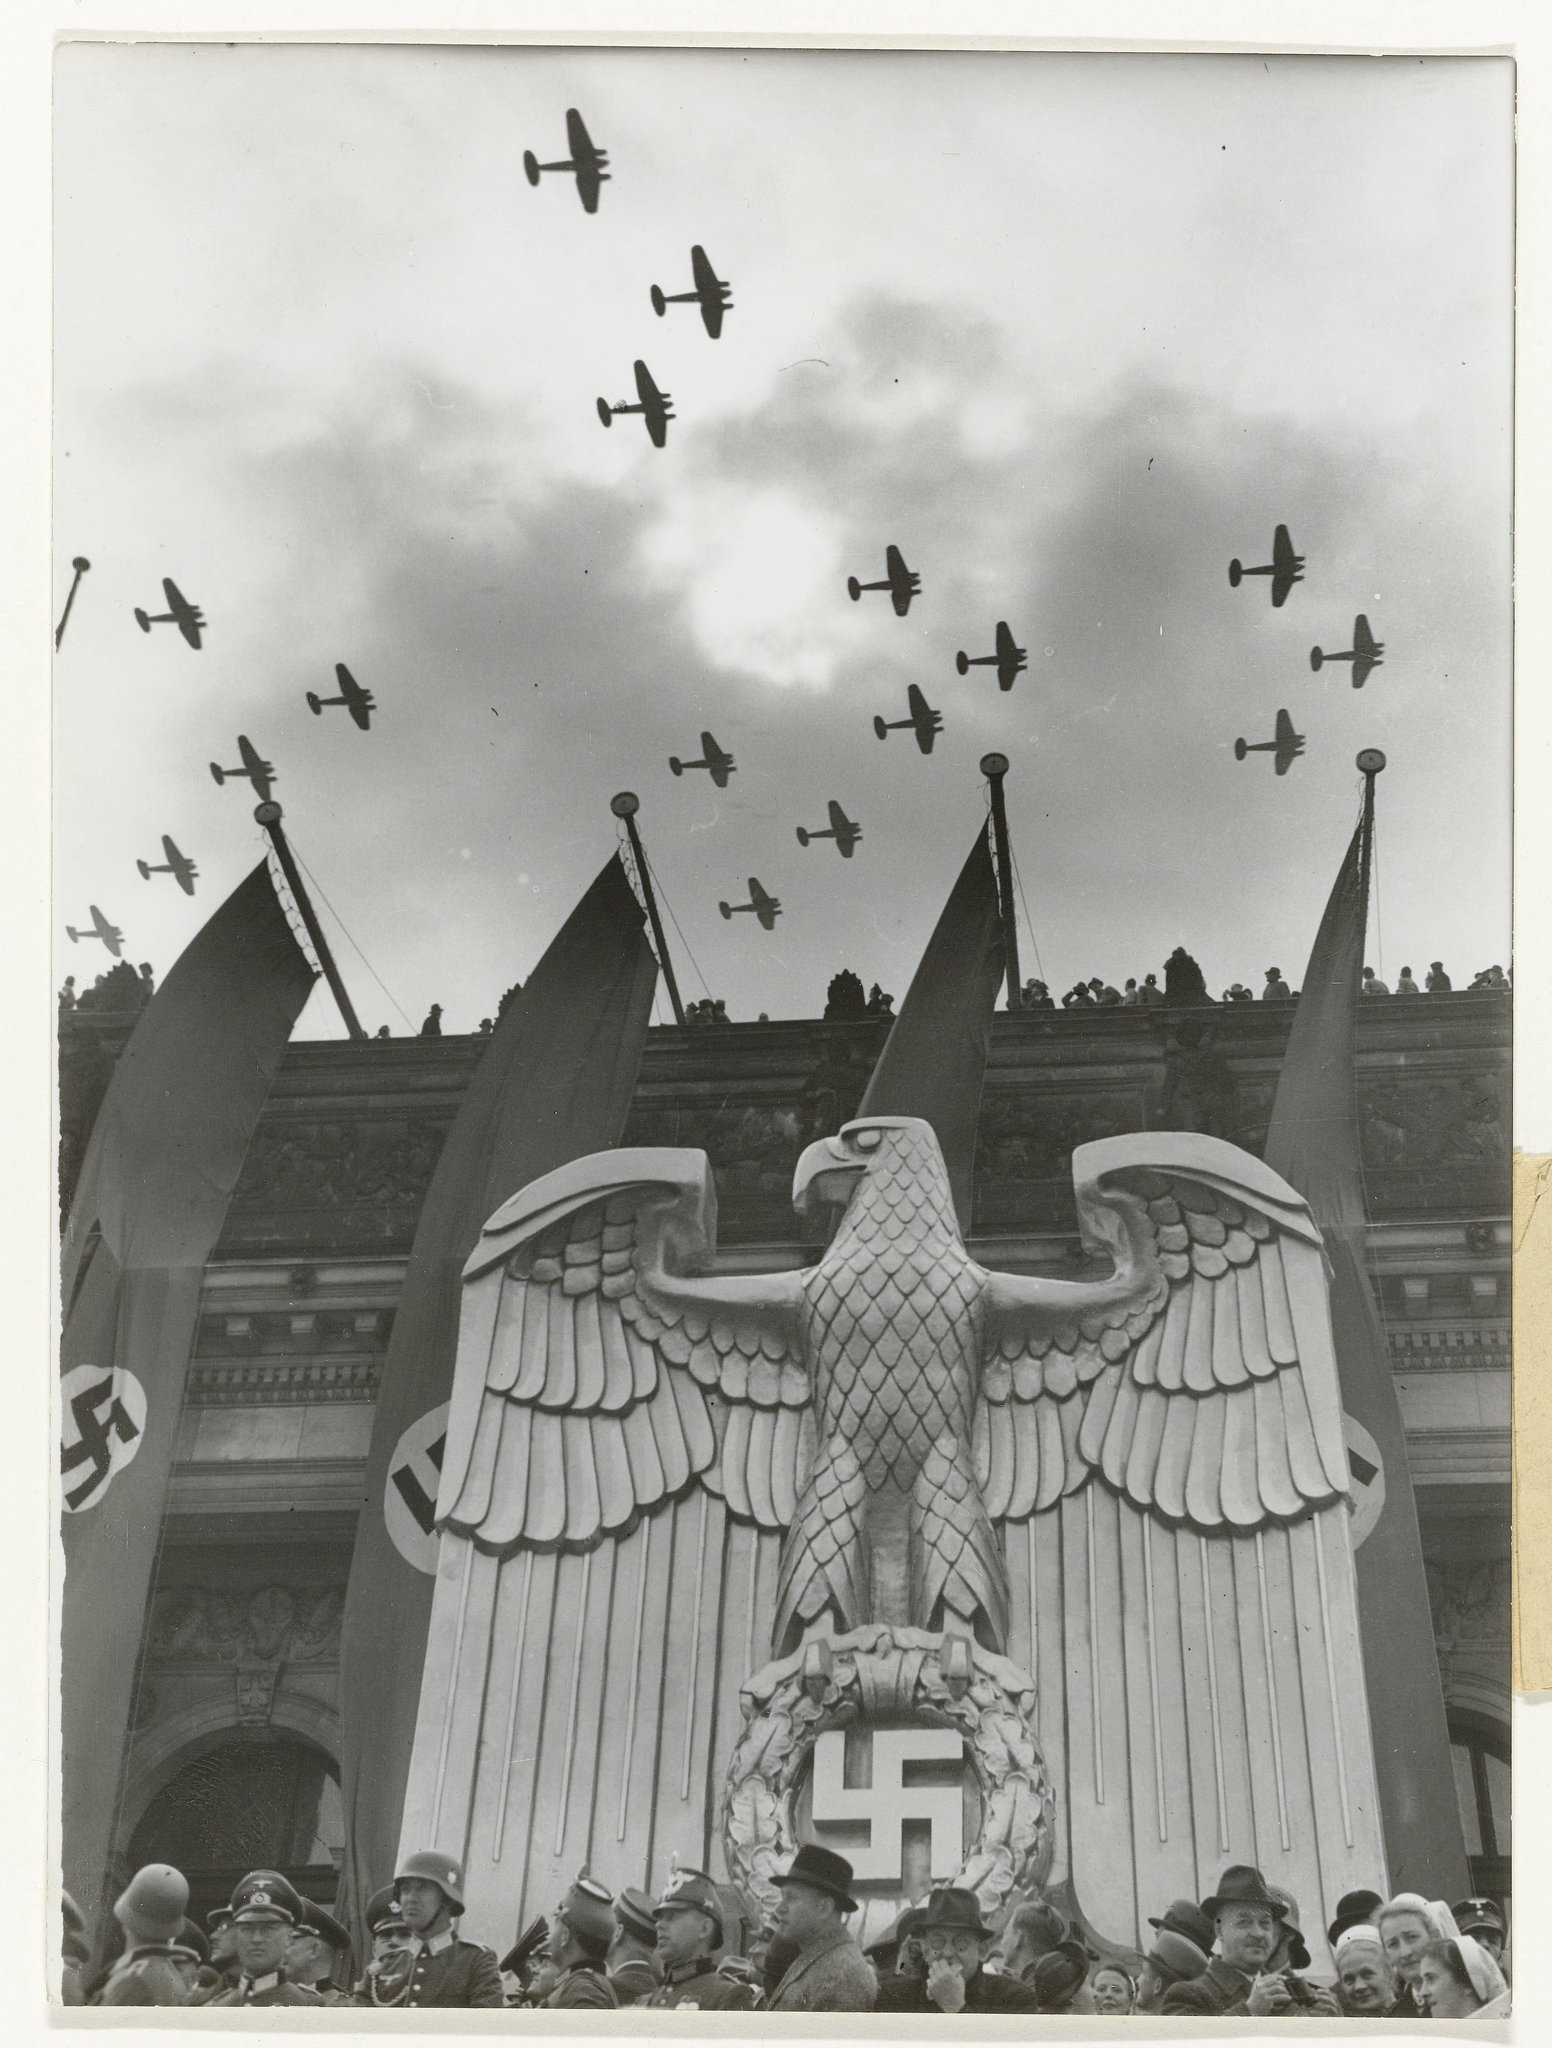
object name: photograph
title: Show van de Duitse Luftwaffe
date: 1939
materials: photographic support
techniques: photography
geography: berlin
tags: berlin, politician, adolf hitler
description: Show van de Duitse Luftwaffe ter ere van Hitlers verjaardag in Charlottenburg, een deel van Berlijn. Op het gebouw op de voorgrond prijkt een Duitse adelaar met swastika